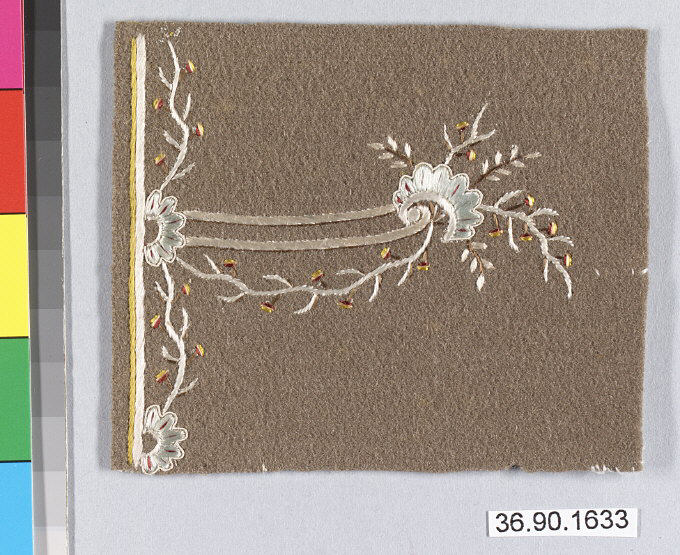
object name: sample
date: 1801-1833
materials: felt, silk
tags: flowers